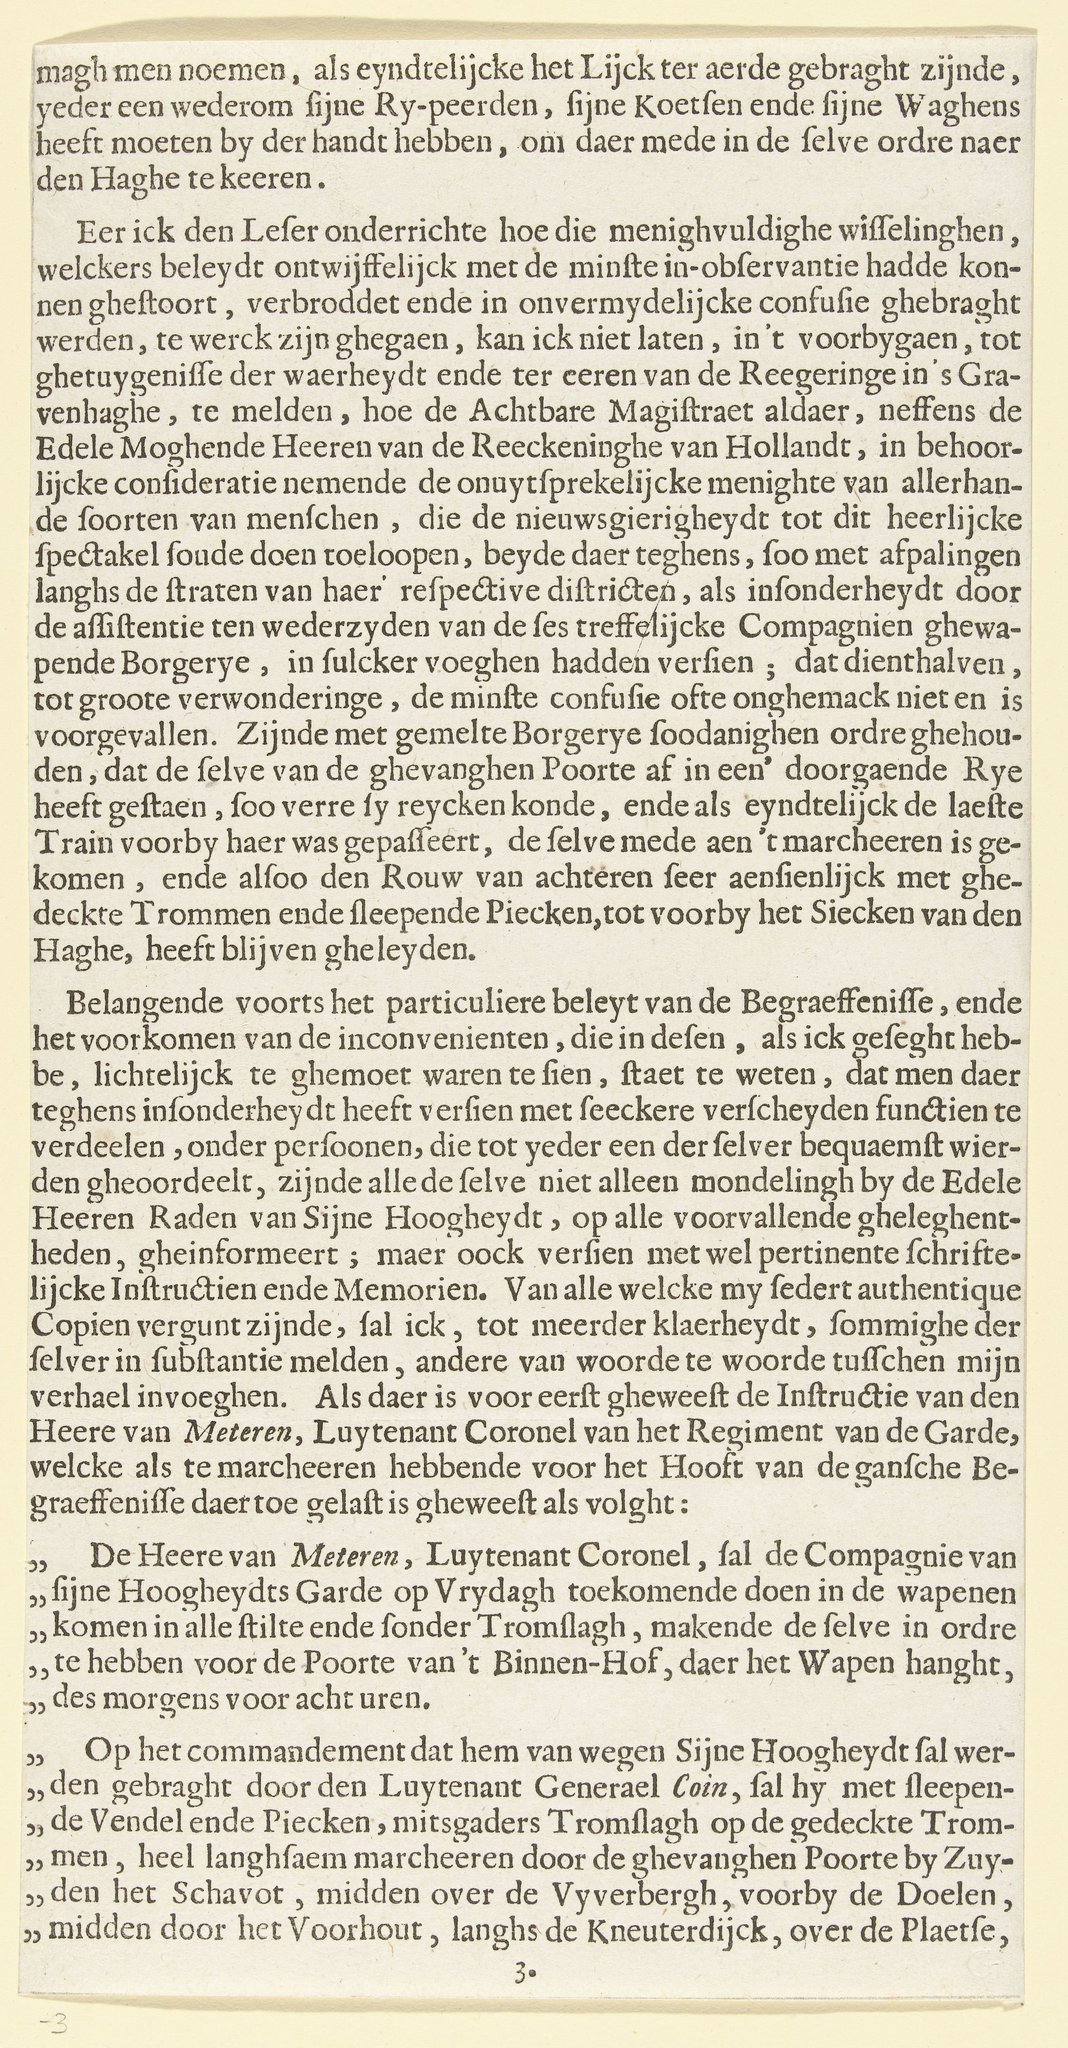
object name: text sheet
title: De begrafenisstoet van stadhouder Frederik Hendrik te 's-Gravenhage in 1647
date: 1651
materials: paper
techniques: letterpress printing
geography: amsterdam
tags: delft, frederick henry (prince of orange), the hague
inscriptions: collector's mark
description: Tekstblad nr. 3 bij de prentserie van de begrafenisstoet van stadhouder Frederik Hendrik te 's-Gravenhage op 10 mei 1647. Onderdeel van een serie van 30 platen en 20 tekstbladen, bedoeld om aan elkaar geplakt te worden.